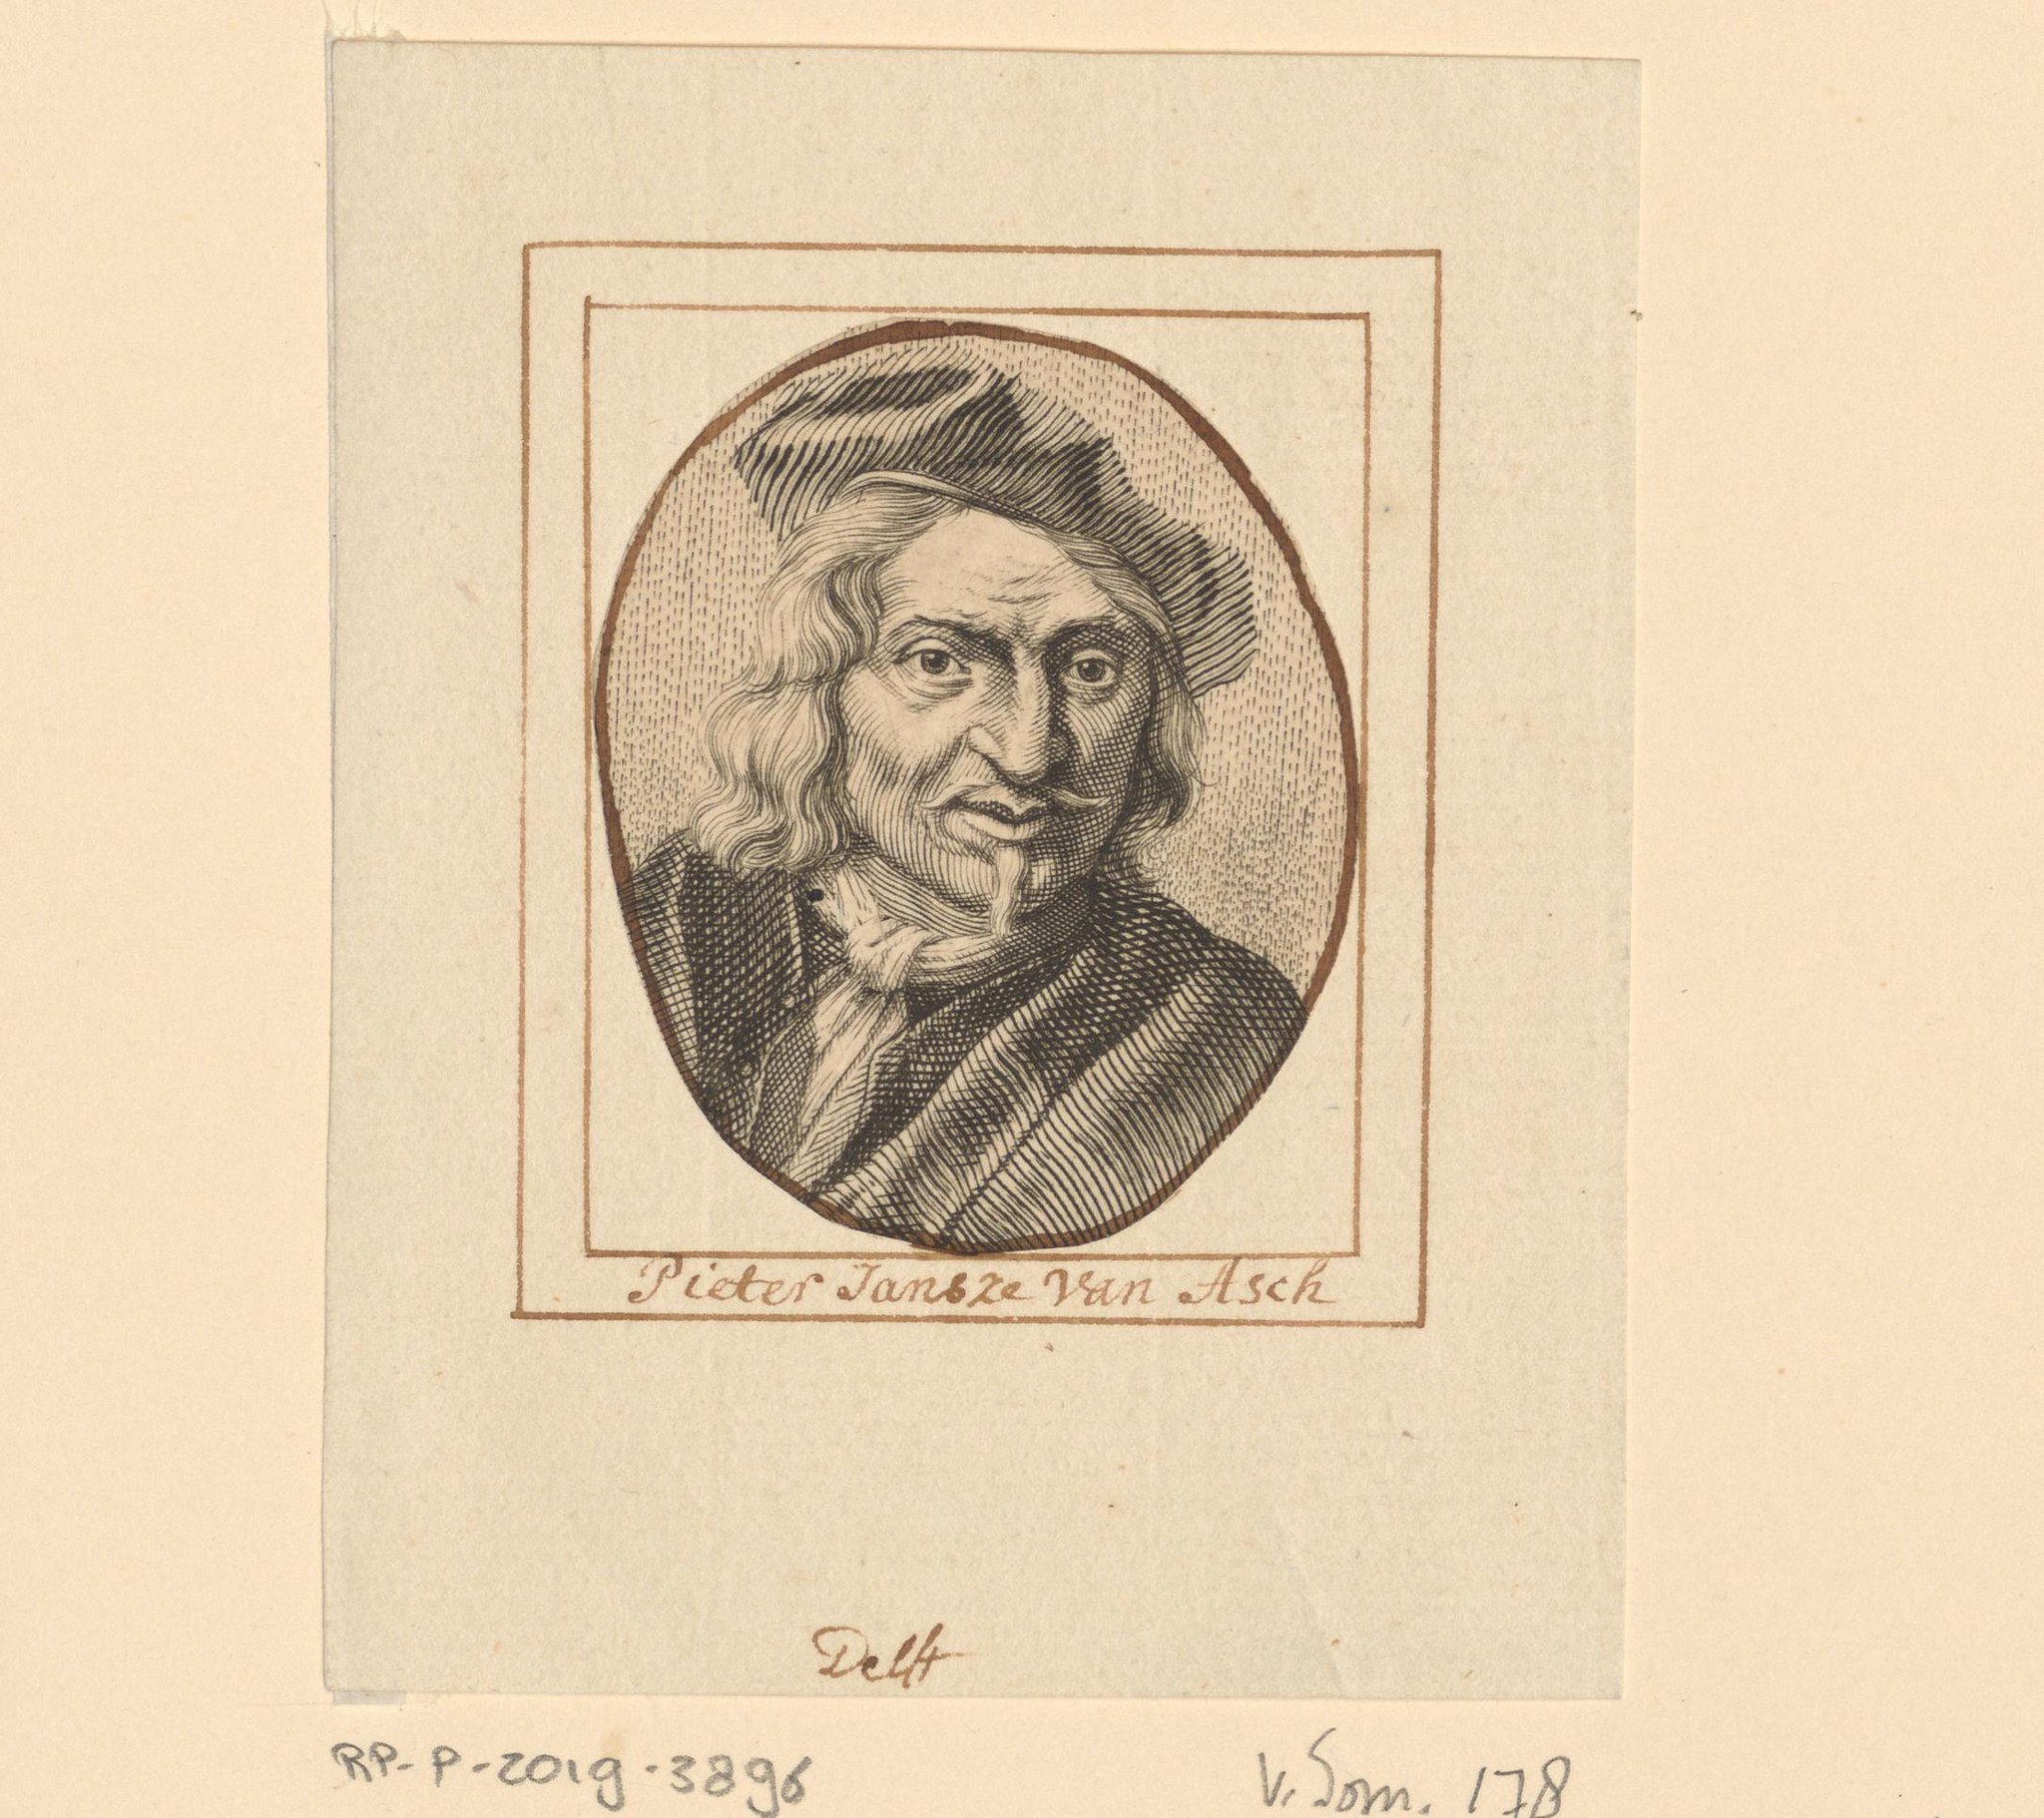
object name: book illustration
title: Portret van Pieter Jansz. van Asch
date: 1718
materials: ink, paper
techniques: engraving, etching, pen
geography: amsterdam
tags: painter, draughtsman, pieter jansz van asch, historical persons, portrait, self-portrait of painter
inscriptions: inscription: ‘Pieter Jansze van Asch/ Delft’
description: Prent afkomstig uit een grotere prent uit: Houbraken, Arnold. De groote schouburgh der Nederlantsche konstschilders en schilderessen. Amsterdam: Arnold Houbraken, 1718, dl. 1. Zie RP-T-1897-A-3450 en RP-T-1897-A-3428 voor de ontwerptekeningen. En zie RP-T-2019-336 voor tekening naar deze prent.